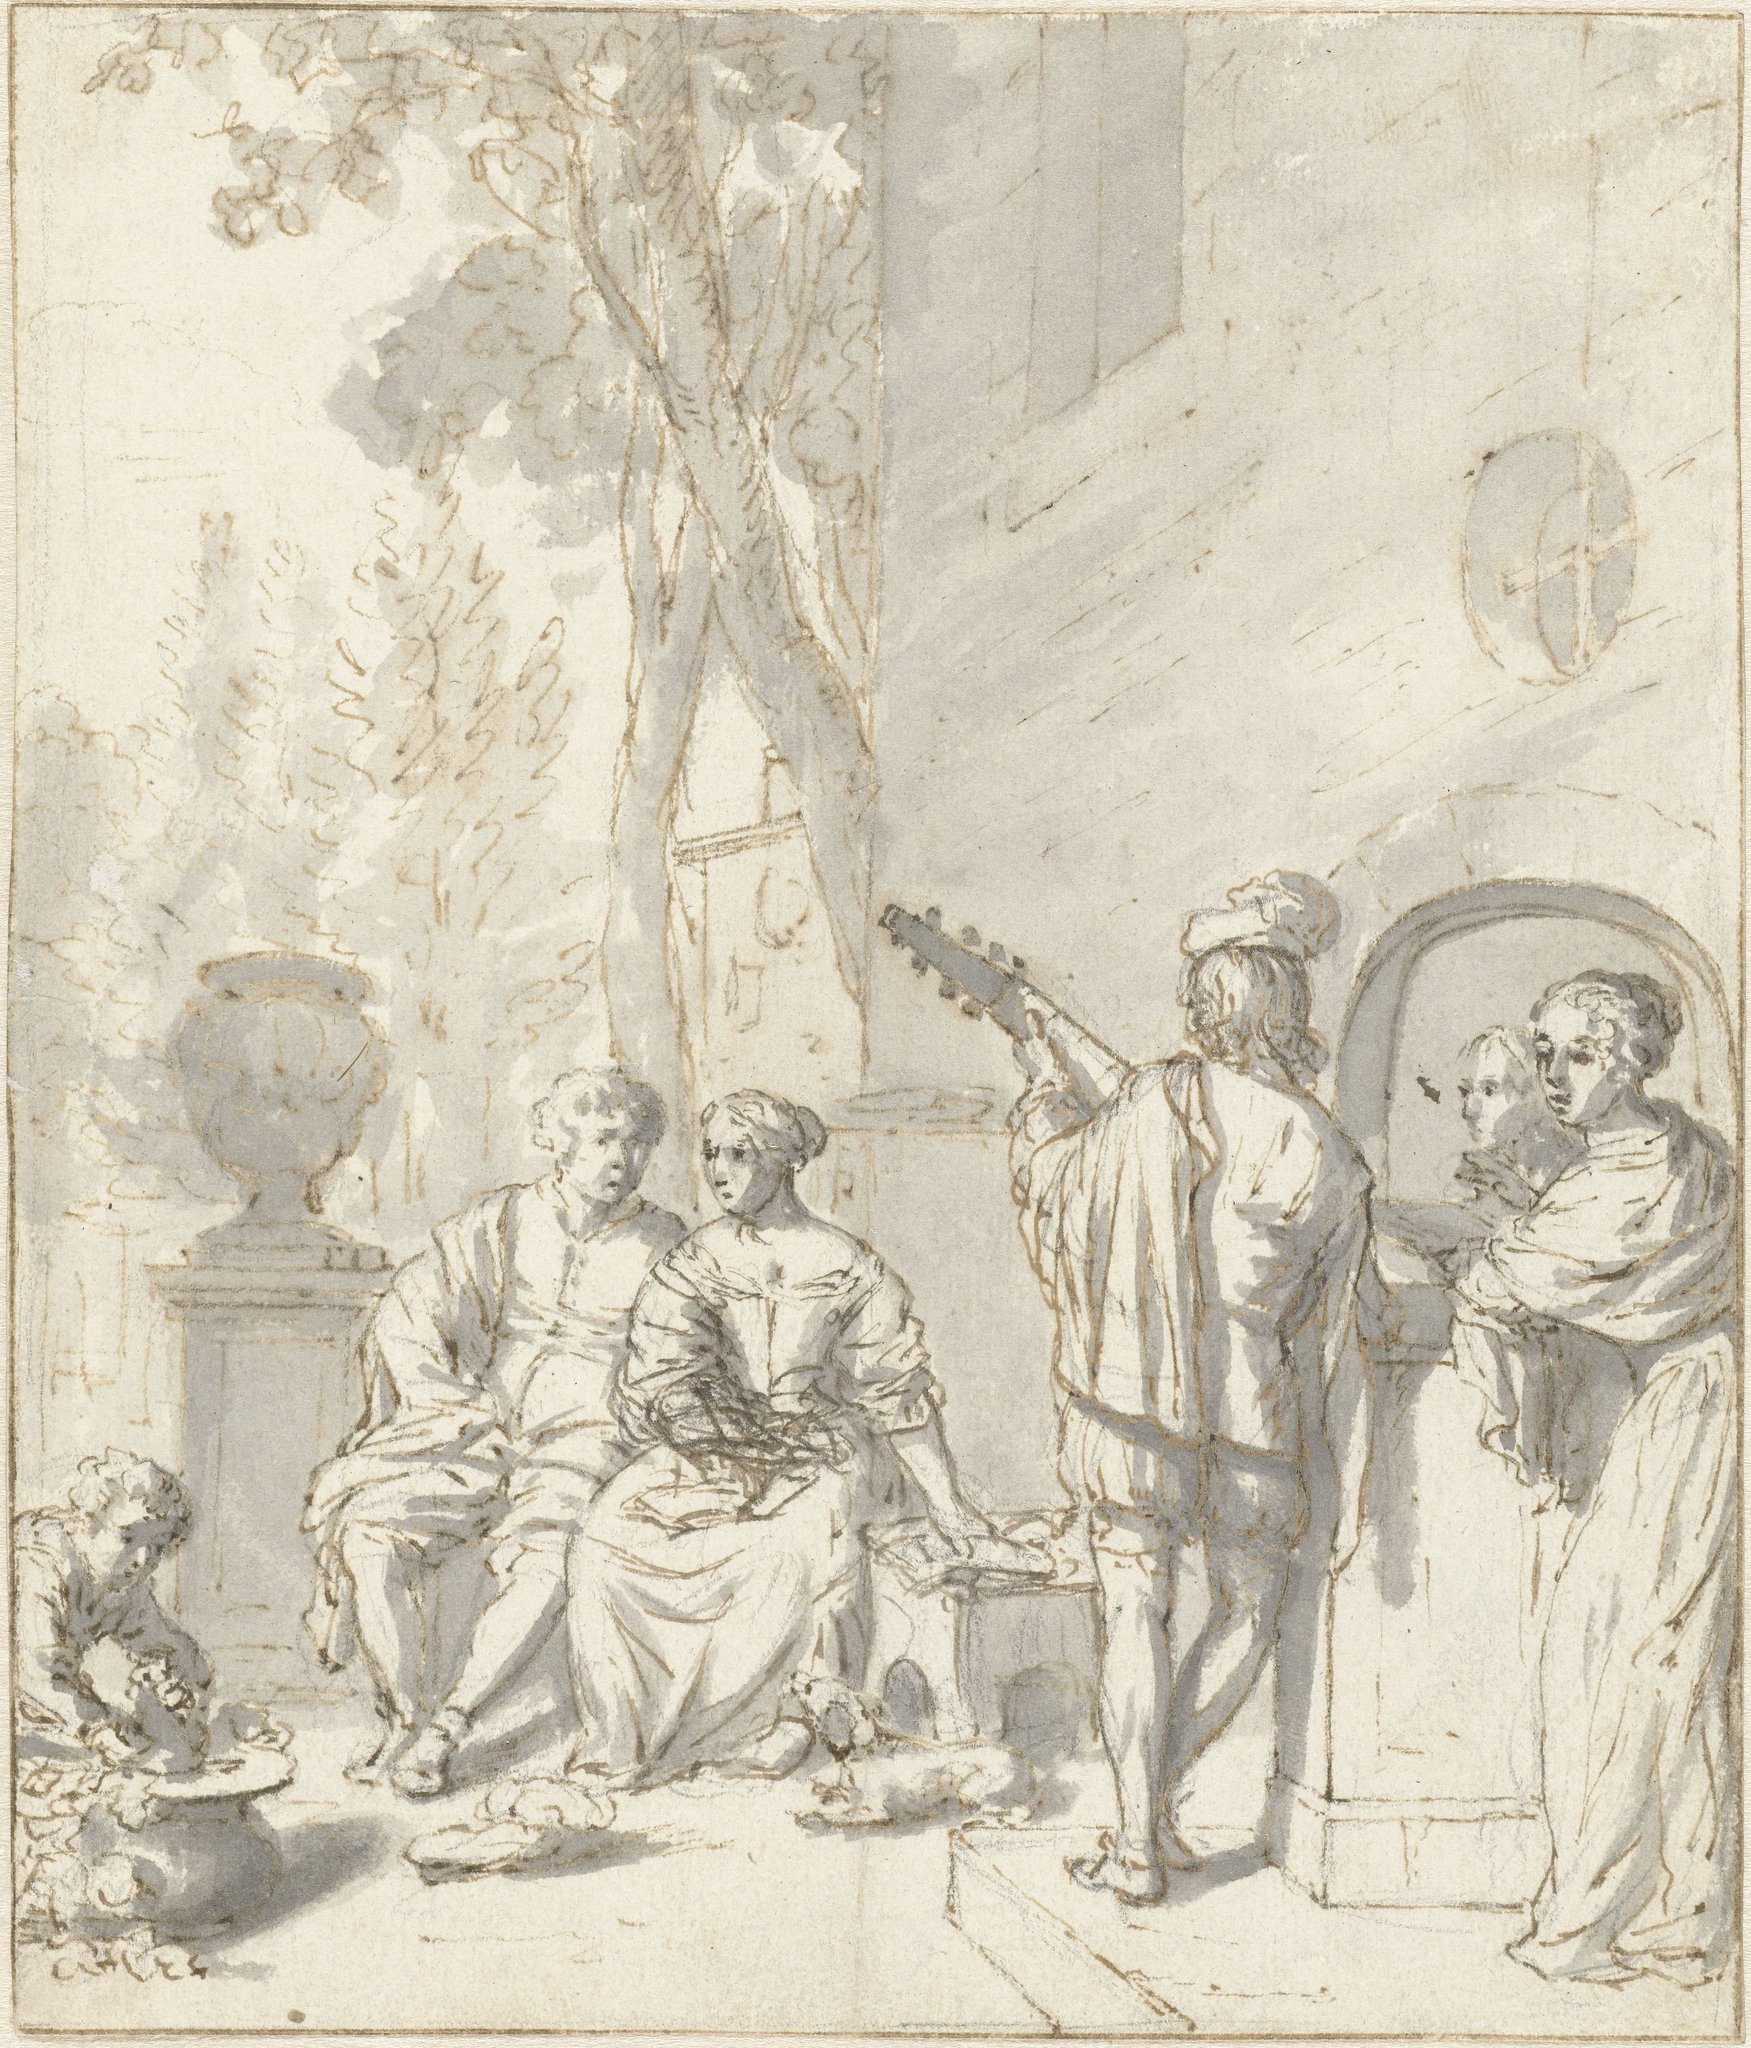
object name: drawing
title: De luitspeler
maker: jan verkolje (i)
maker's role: draughtsman, painter, print maker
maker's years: 1650-1693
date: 1660-1693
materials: chalk, ink, paper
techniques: brush, pen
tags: visiting; receiving guests; elegant company, one person playing string instrument (plucked), lute, and special forms of lute, e.g.: theorbo